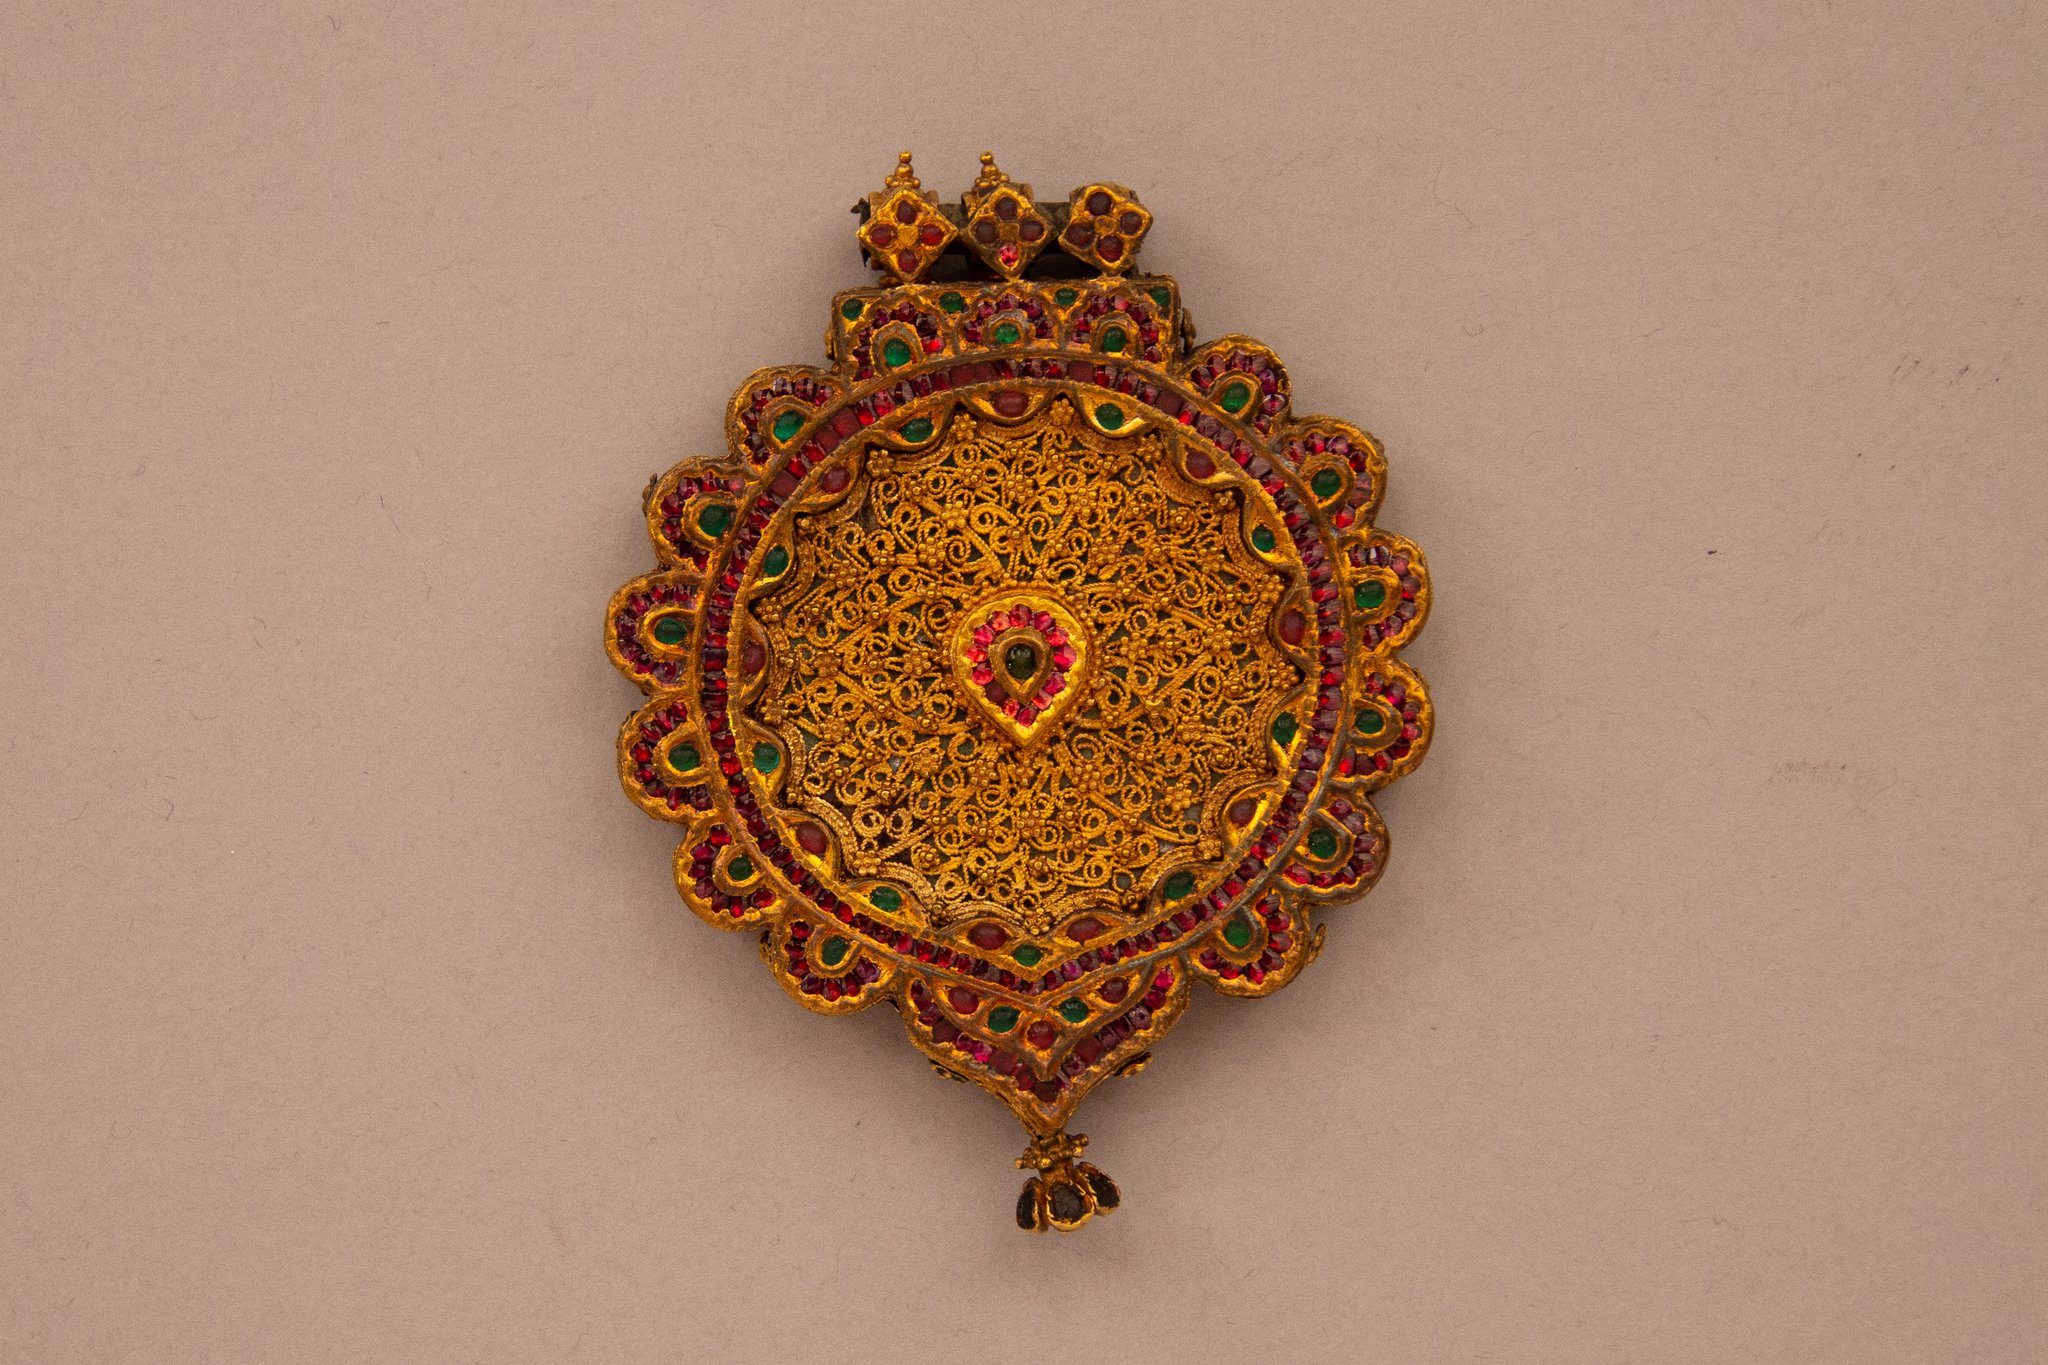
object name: pendant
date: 1801-1900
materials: gemstone, gold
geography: northern india